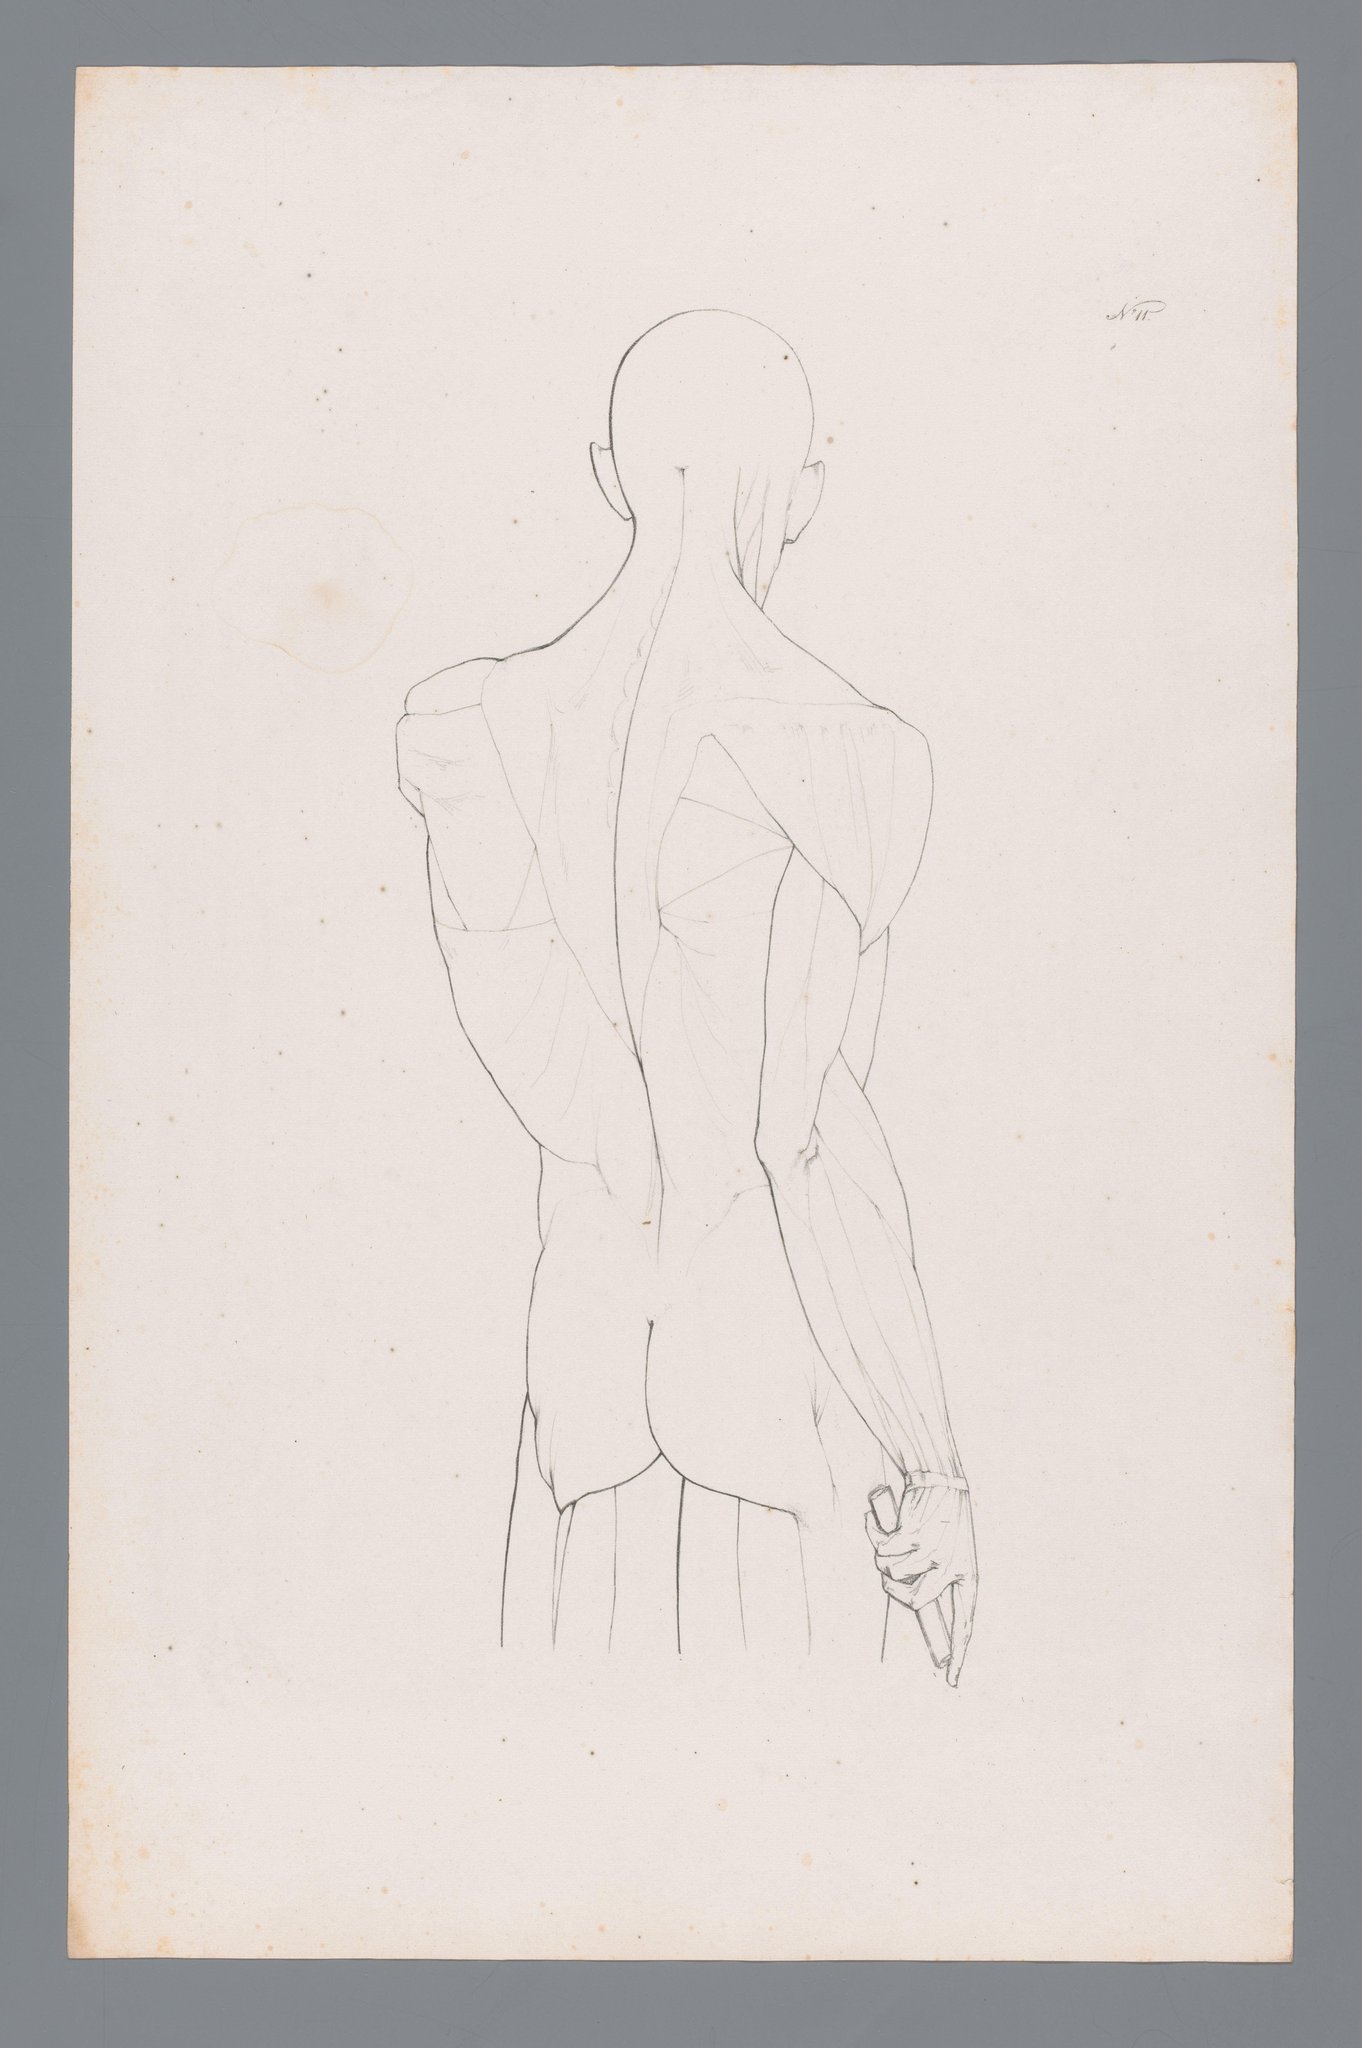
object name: print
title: Anatomie van een bovenlichaam op de rug gezien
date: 1828-1830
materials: paper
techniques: lithograph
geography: amsterdam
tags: back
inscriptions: collector's mark: Lugt 2228, collector's mark: Lugt 2760, watermark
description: Onderdeel van een omslag met een serie van twaalf anatomische voorstellingen.